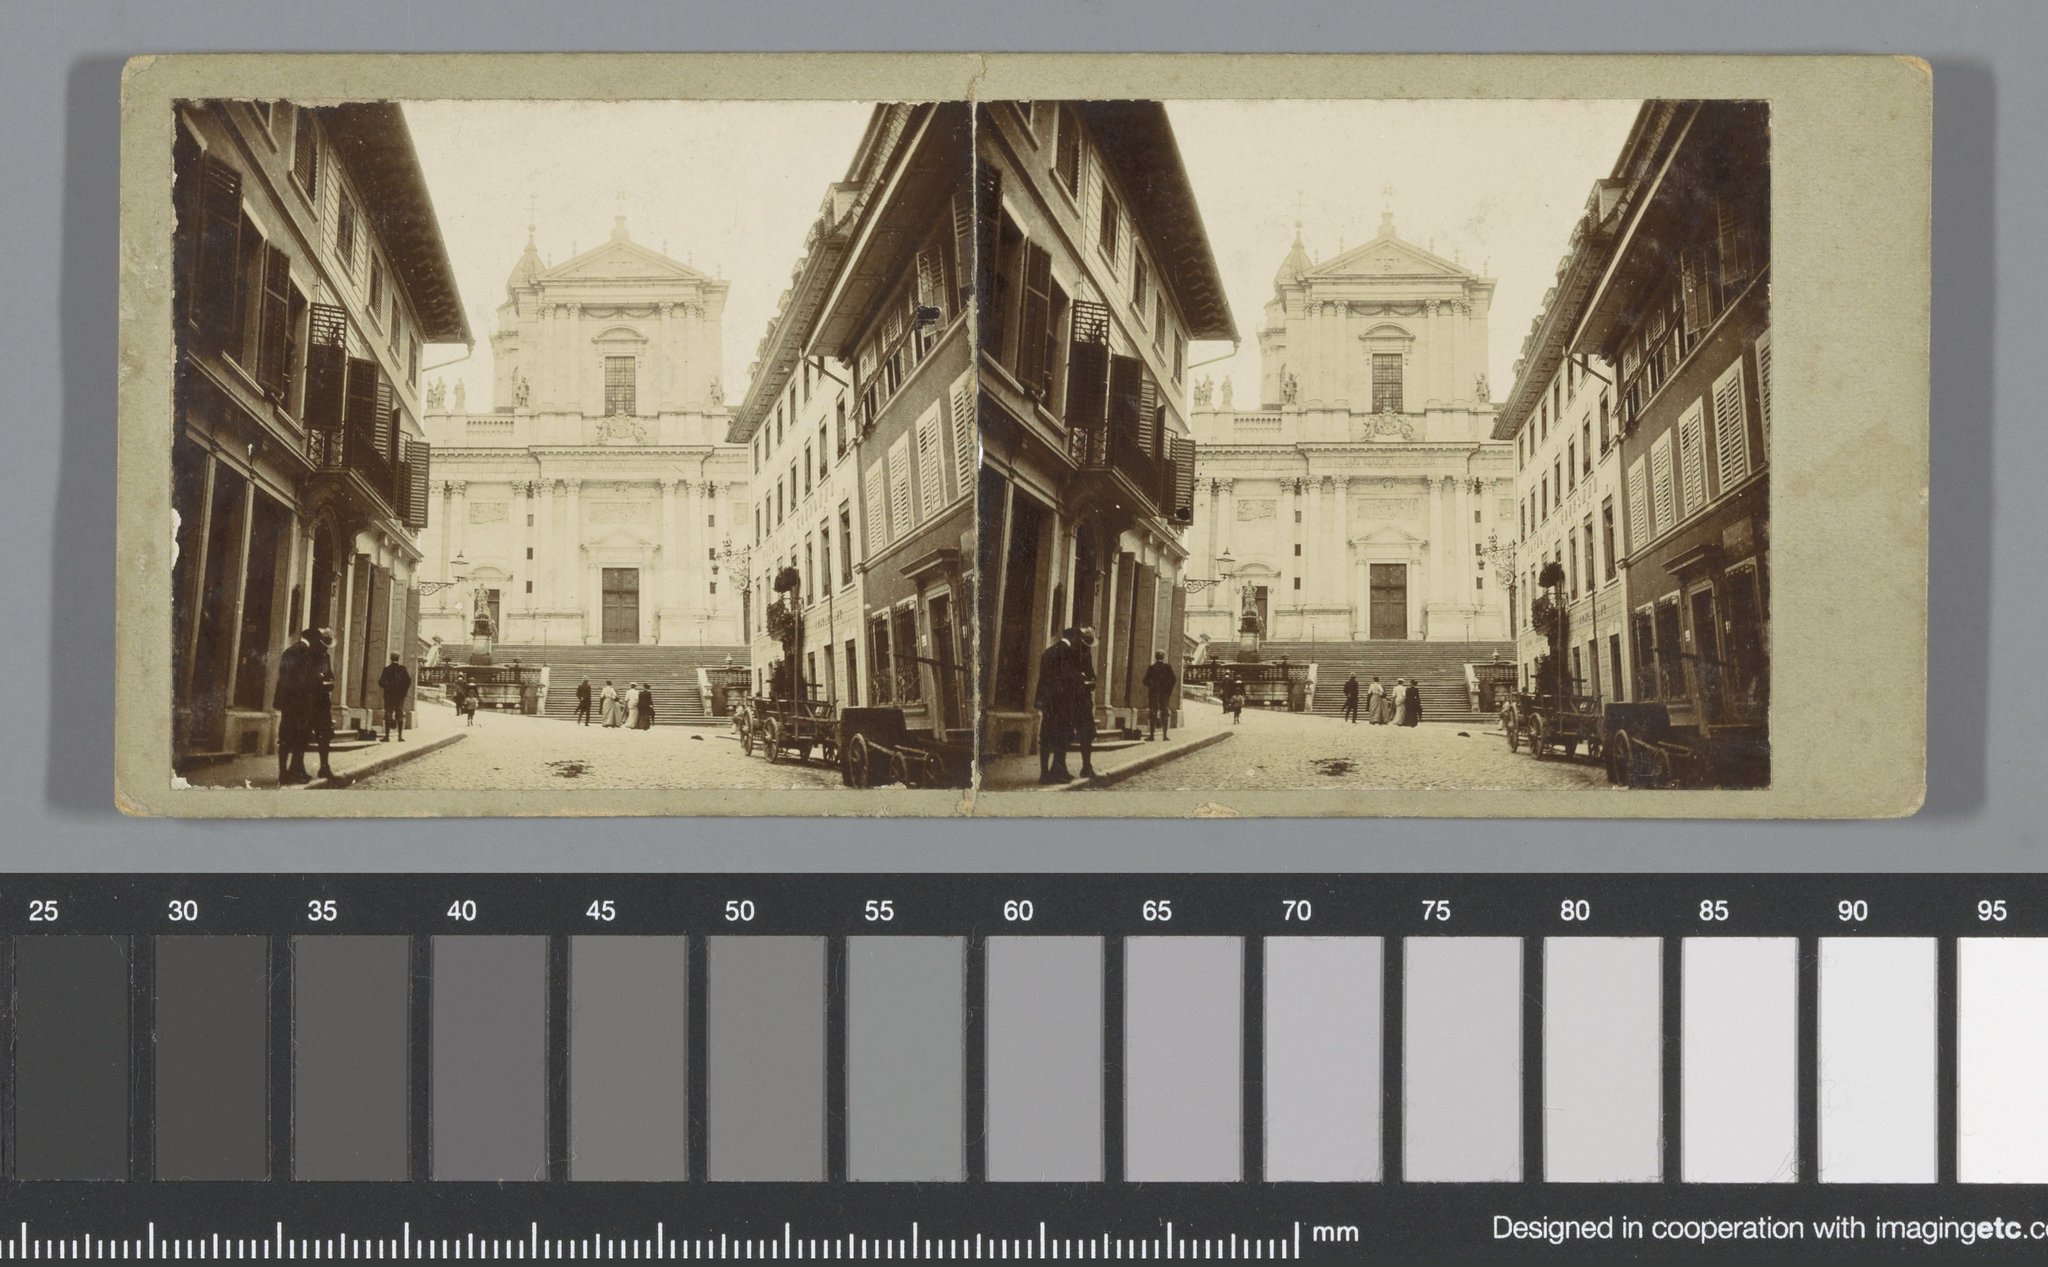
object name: stereograph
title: Gezicht op de kathedraal van Solothurn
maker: Anonymous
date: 1882-1910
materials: paper, cardboard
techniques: gelatin silver print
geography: solothurn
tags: parts of church exterior and annexes: façade, solothurn cathedral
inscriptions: number: ‘6’